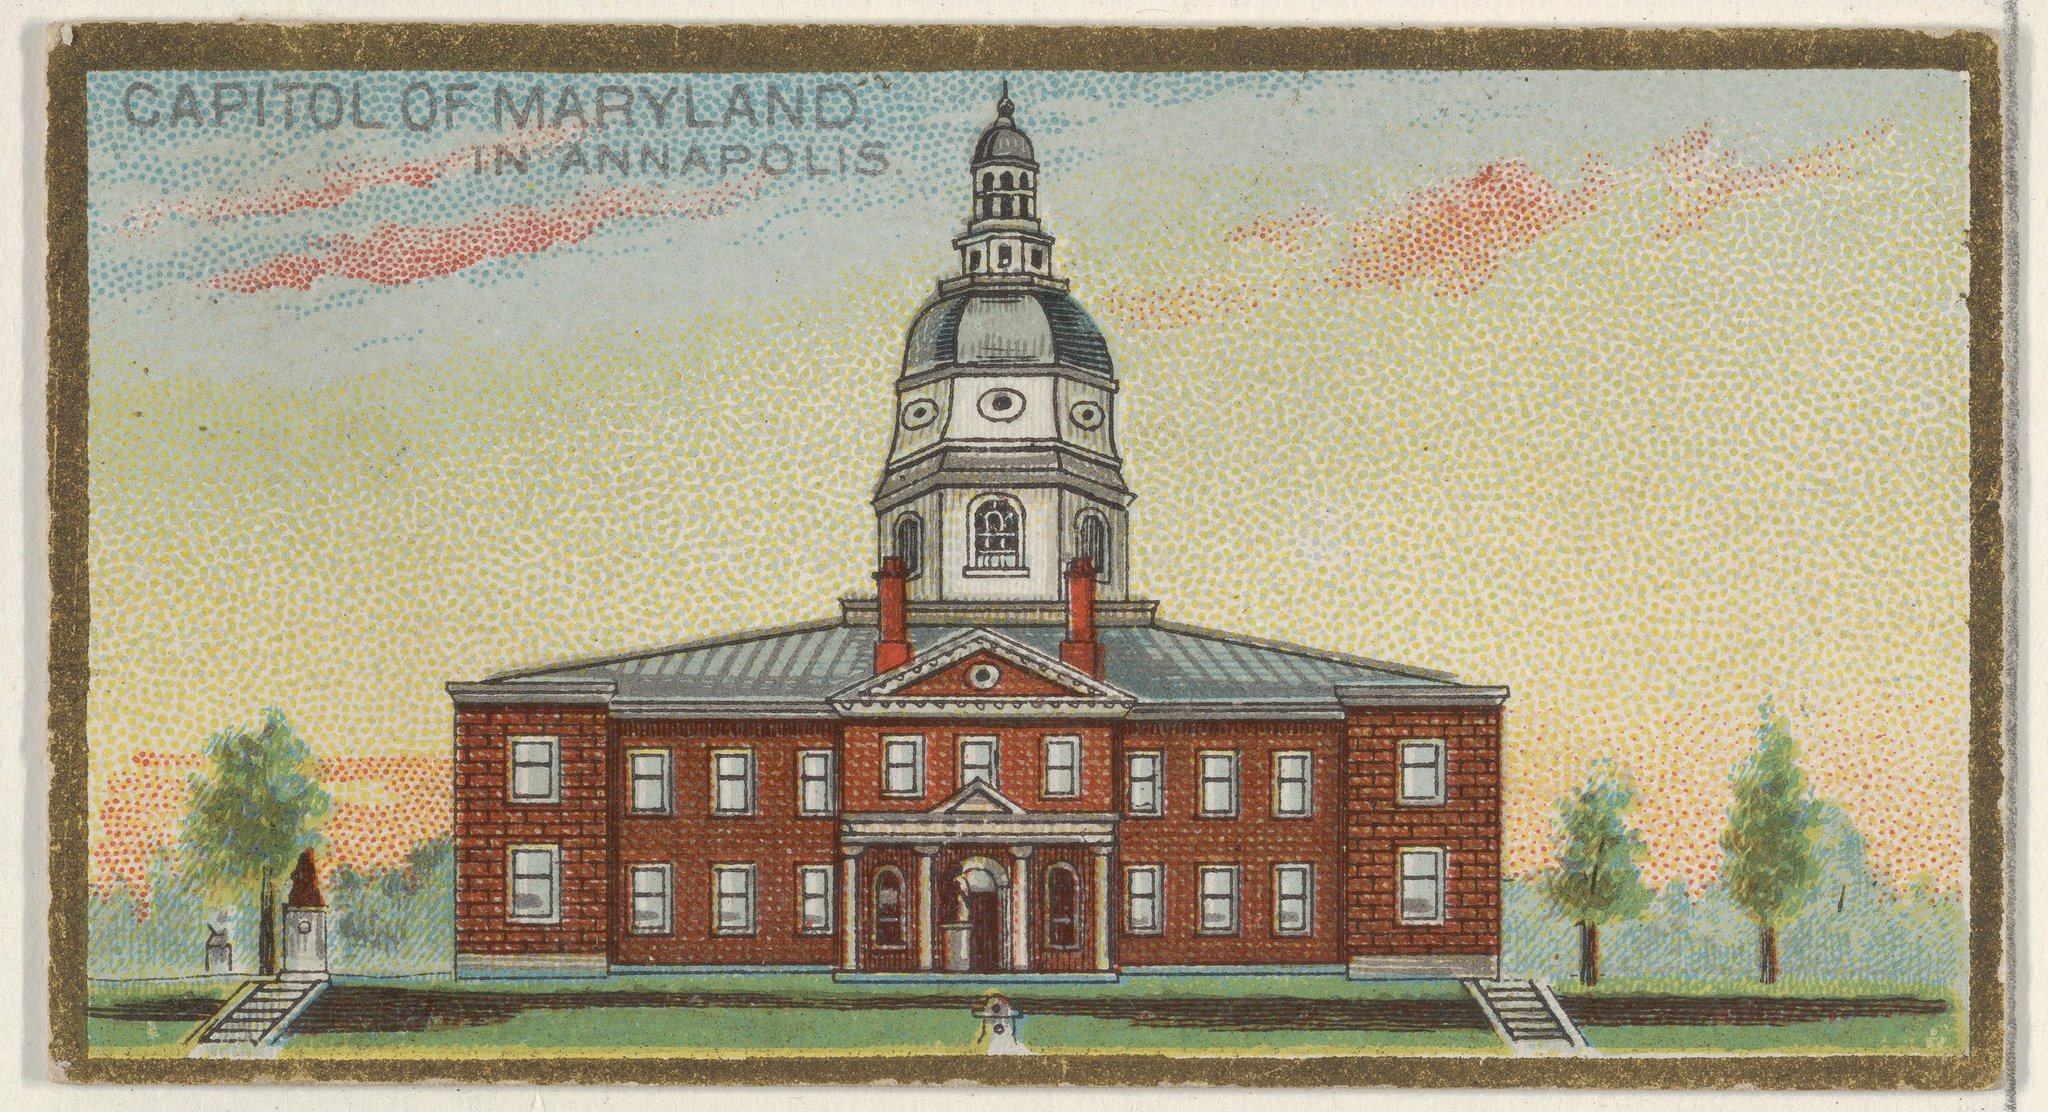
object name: print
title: Capitol of Maryland in Annapolis, from the General Government and State Capitol Buildings series (N14) for Allen & Ginter Cigarettes Brands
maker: allen & ginter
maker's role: publisher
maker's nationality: american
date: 1889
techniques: color lithograph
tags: buildings